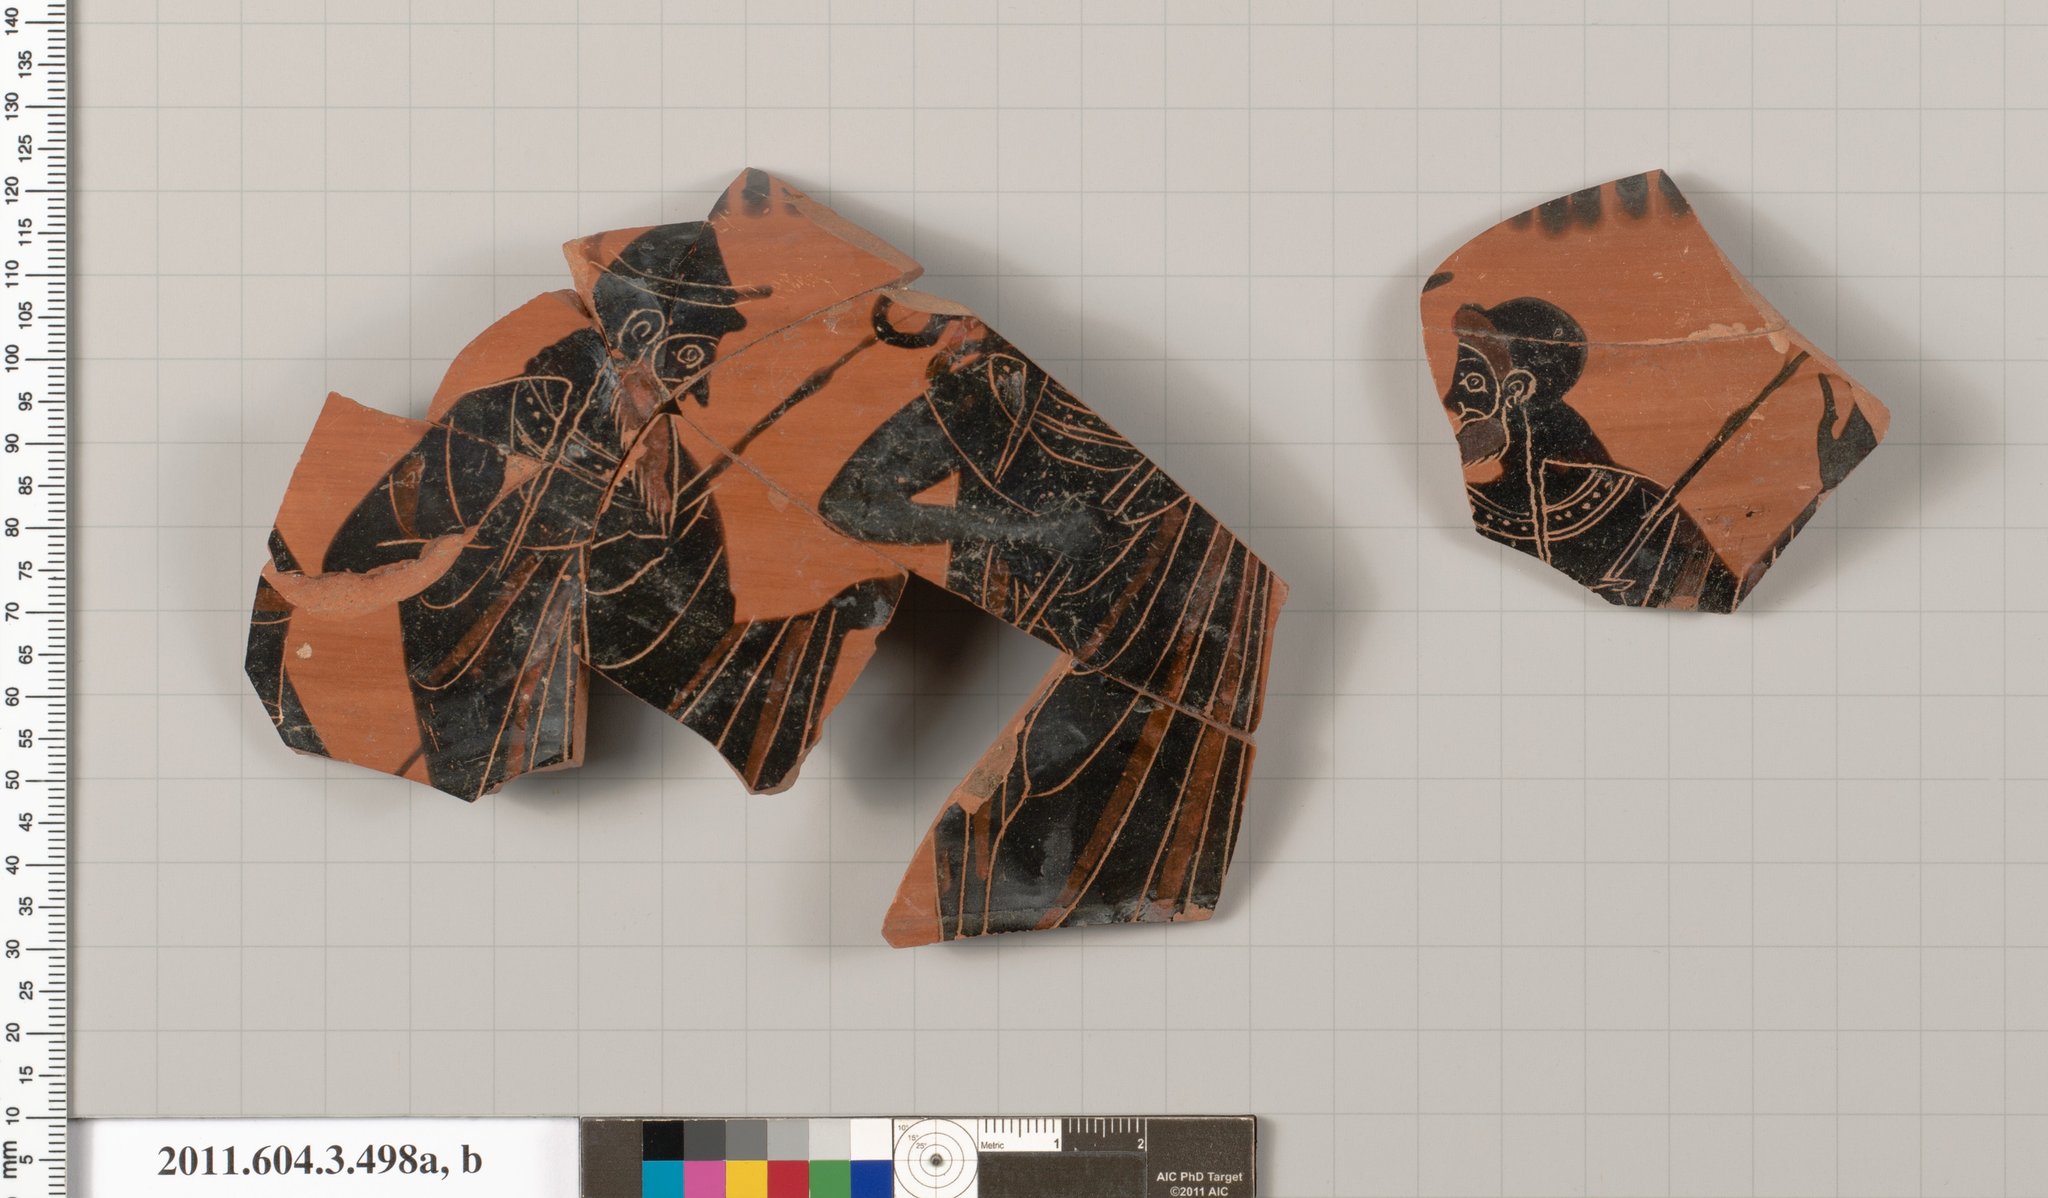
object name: column krater fragment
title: Terracotta fragments of a column-krater (bowl for mixing wine and water)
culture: greek, attic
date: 550-526 BCE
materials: terracotta